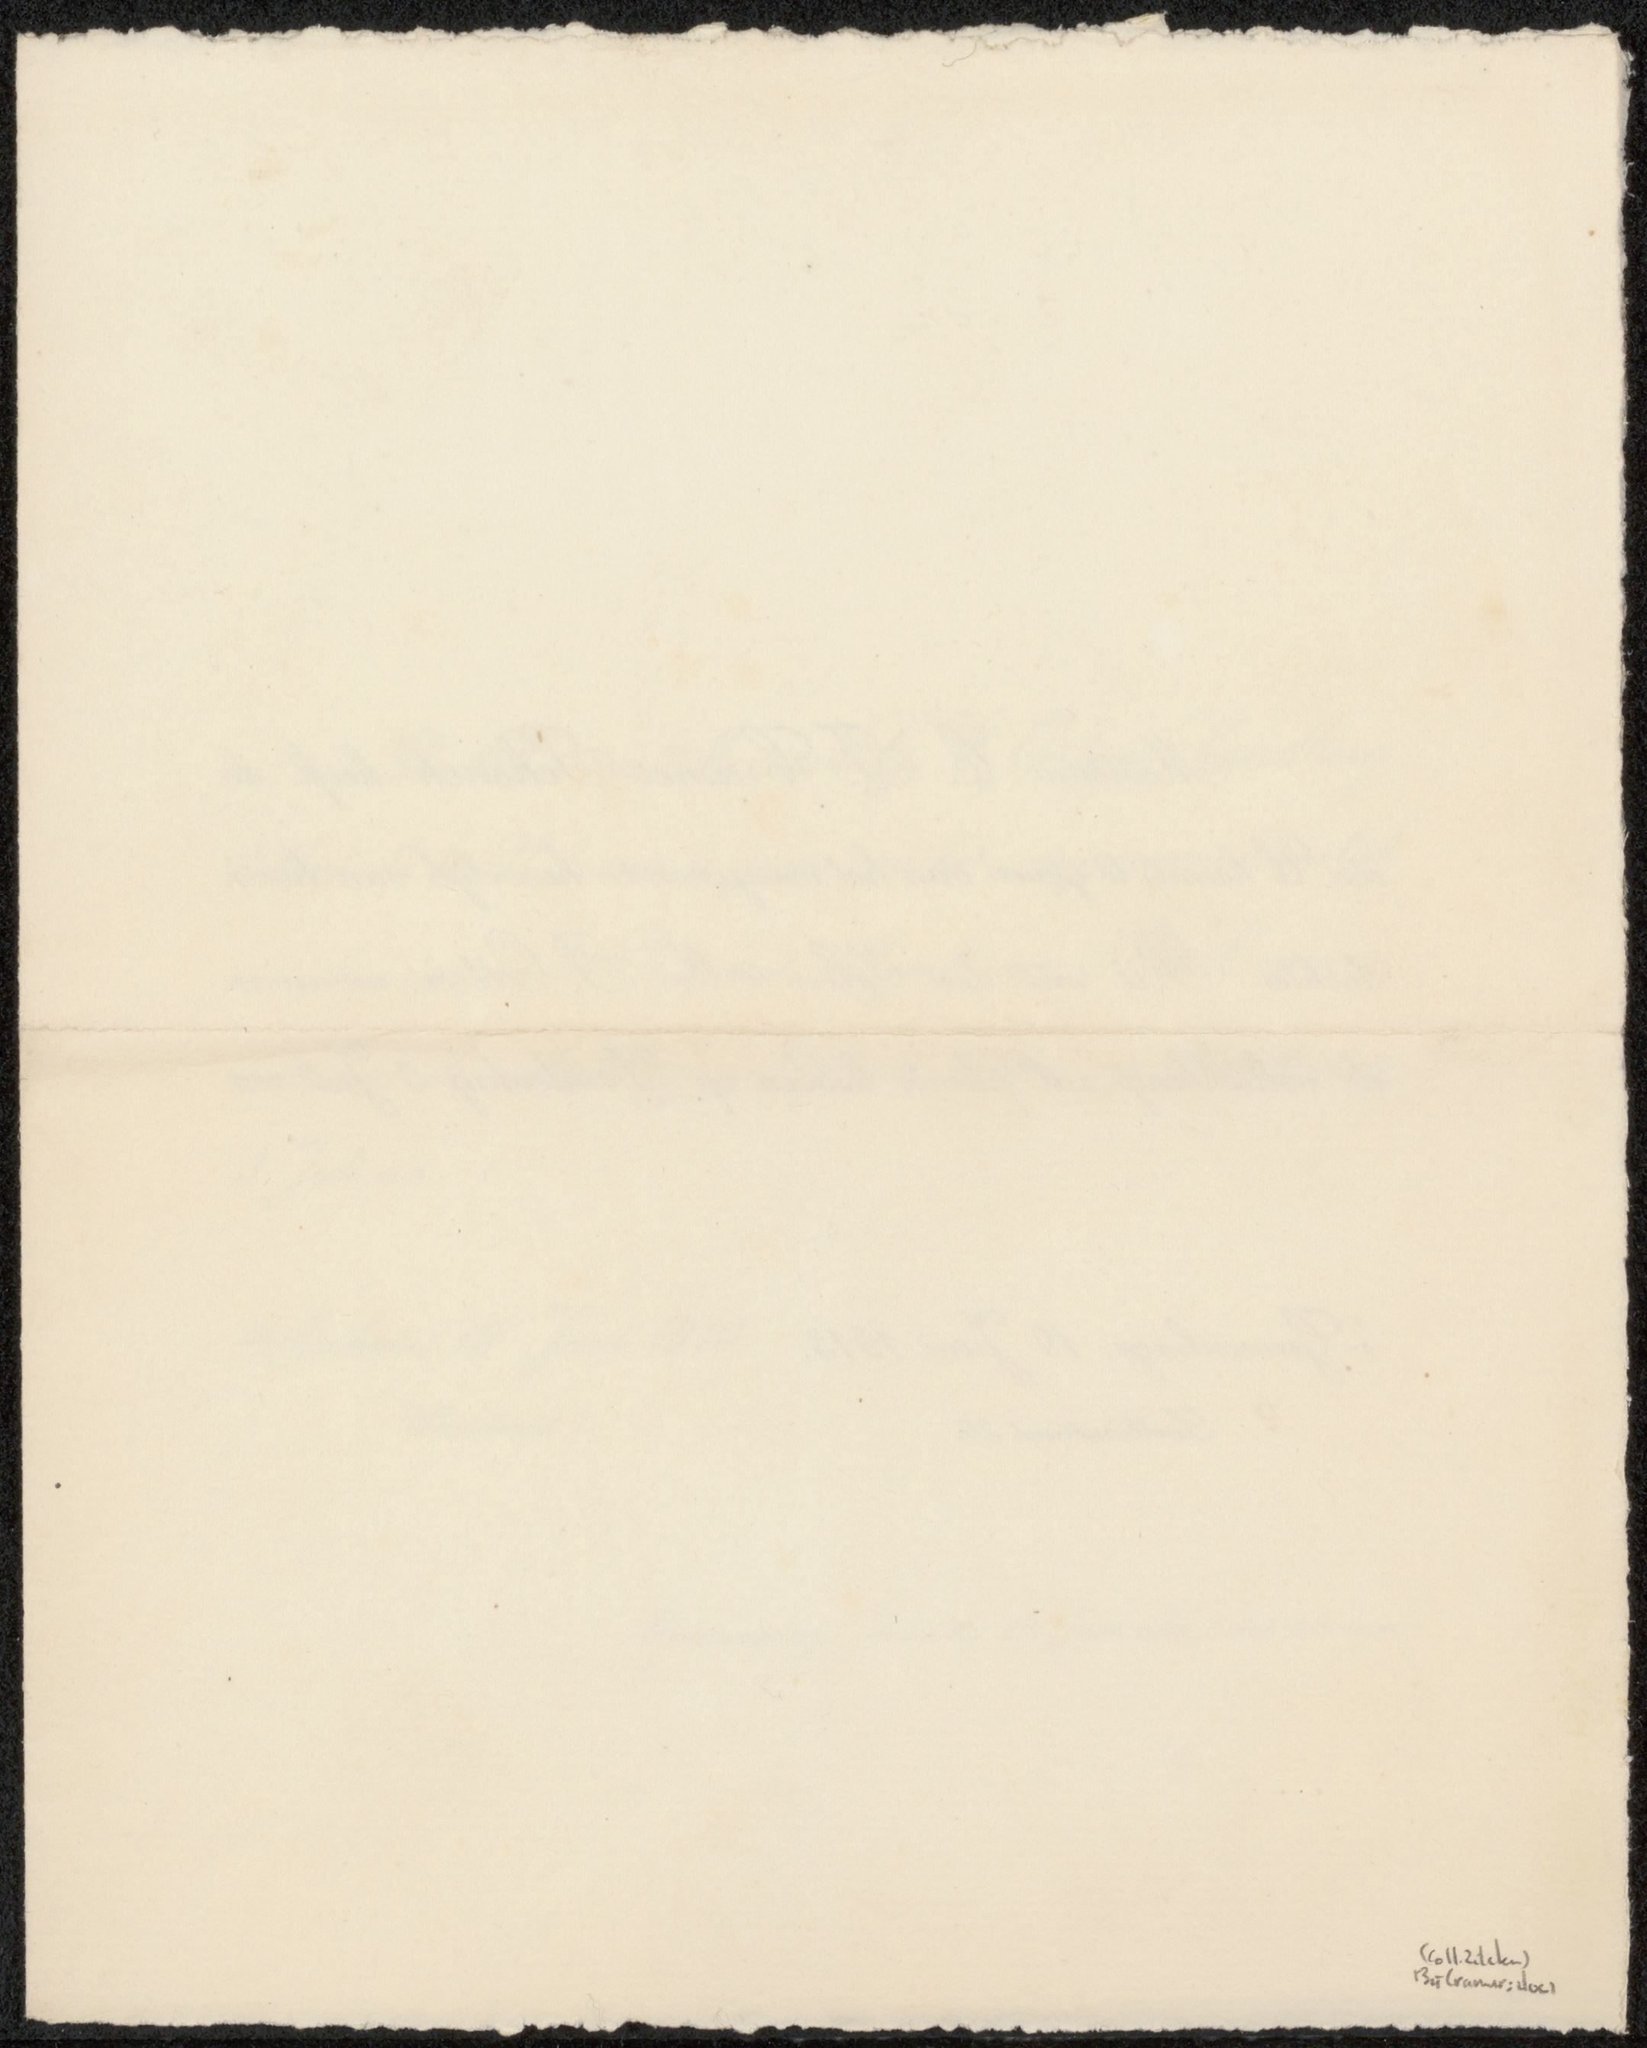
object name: wedding announcement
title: Huwelijksaankondiging aan Philip Zilcken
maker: Anonymous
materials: paper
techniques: printing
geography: netherlands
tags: print maker, draughtsman, rie cramer, the hague, amsterdam, painter, philip zilcken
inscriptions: collector's mark: ‘RPK’, watermark